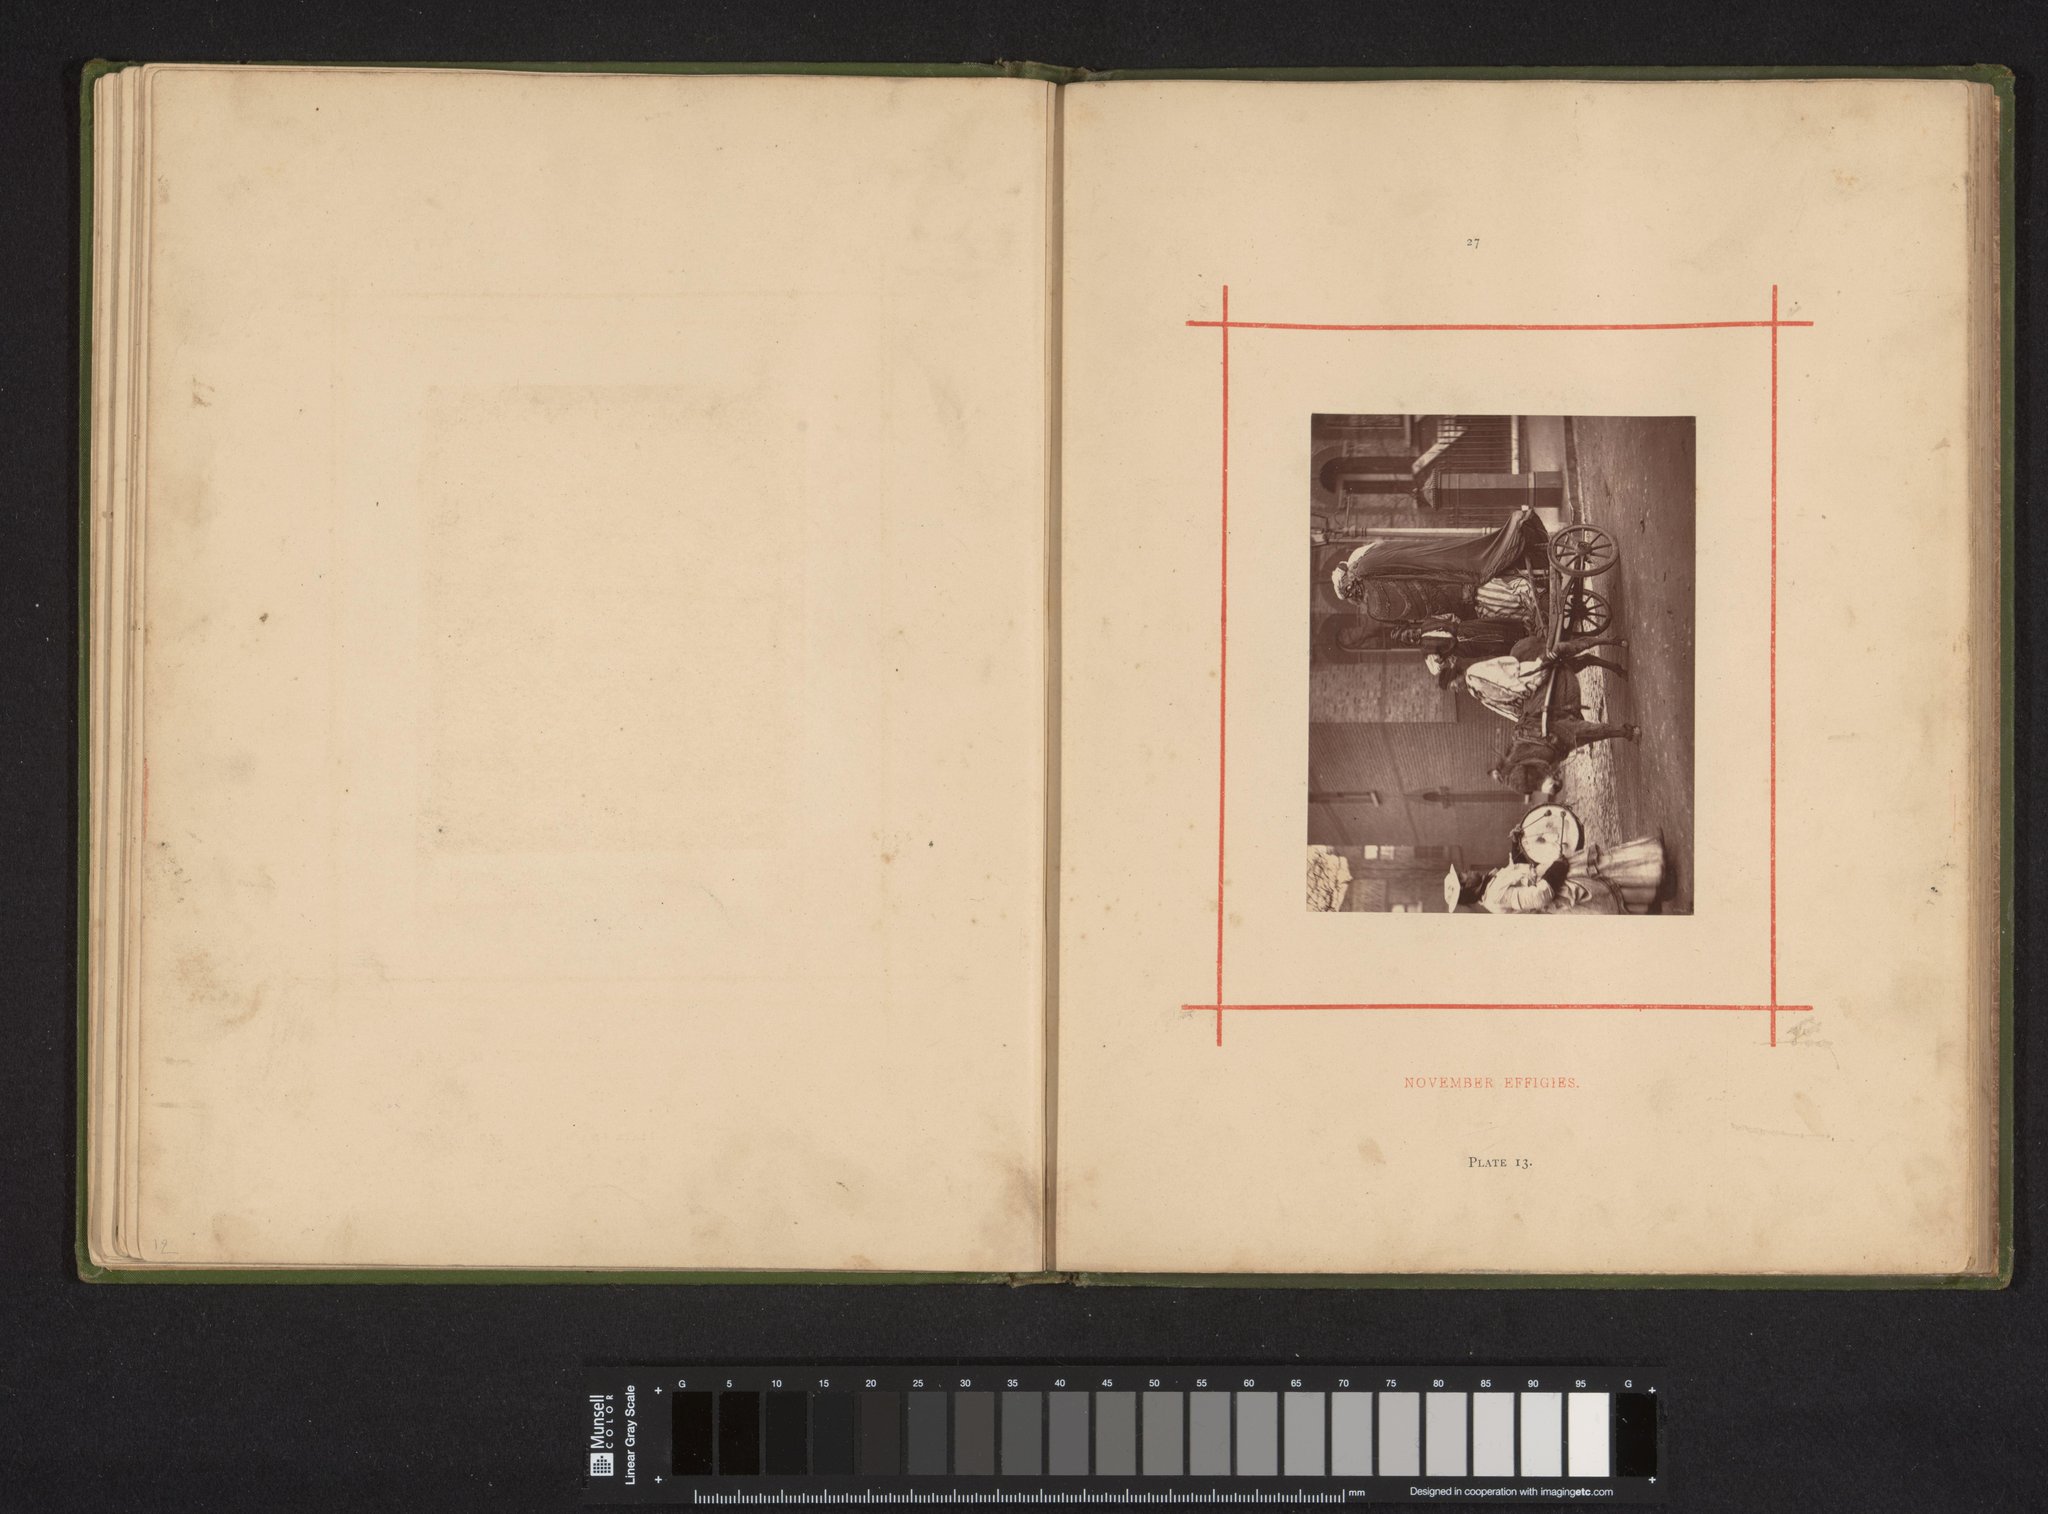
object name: photomechanical print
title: November effigies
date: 1871-1881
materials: paper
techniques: woodburytype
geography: london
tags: ass, donkey, periodic celebrations, popular feasts (+ decorated float, wagon ~ festive activities)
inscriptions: number: ‘Plate 13.’